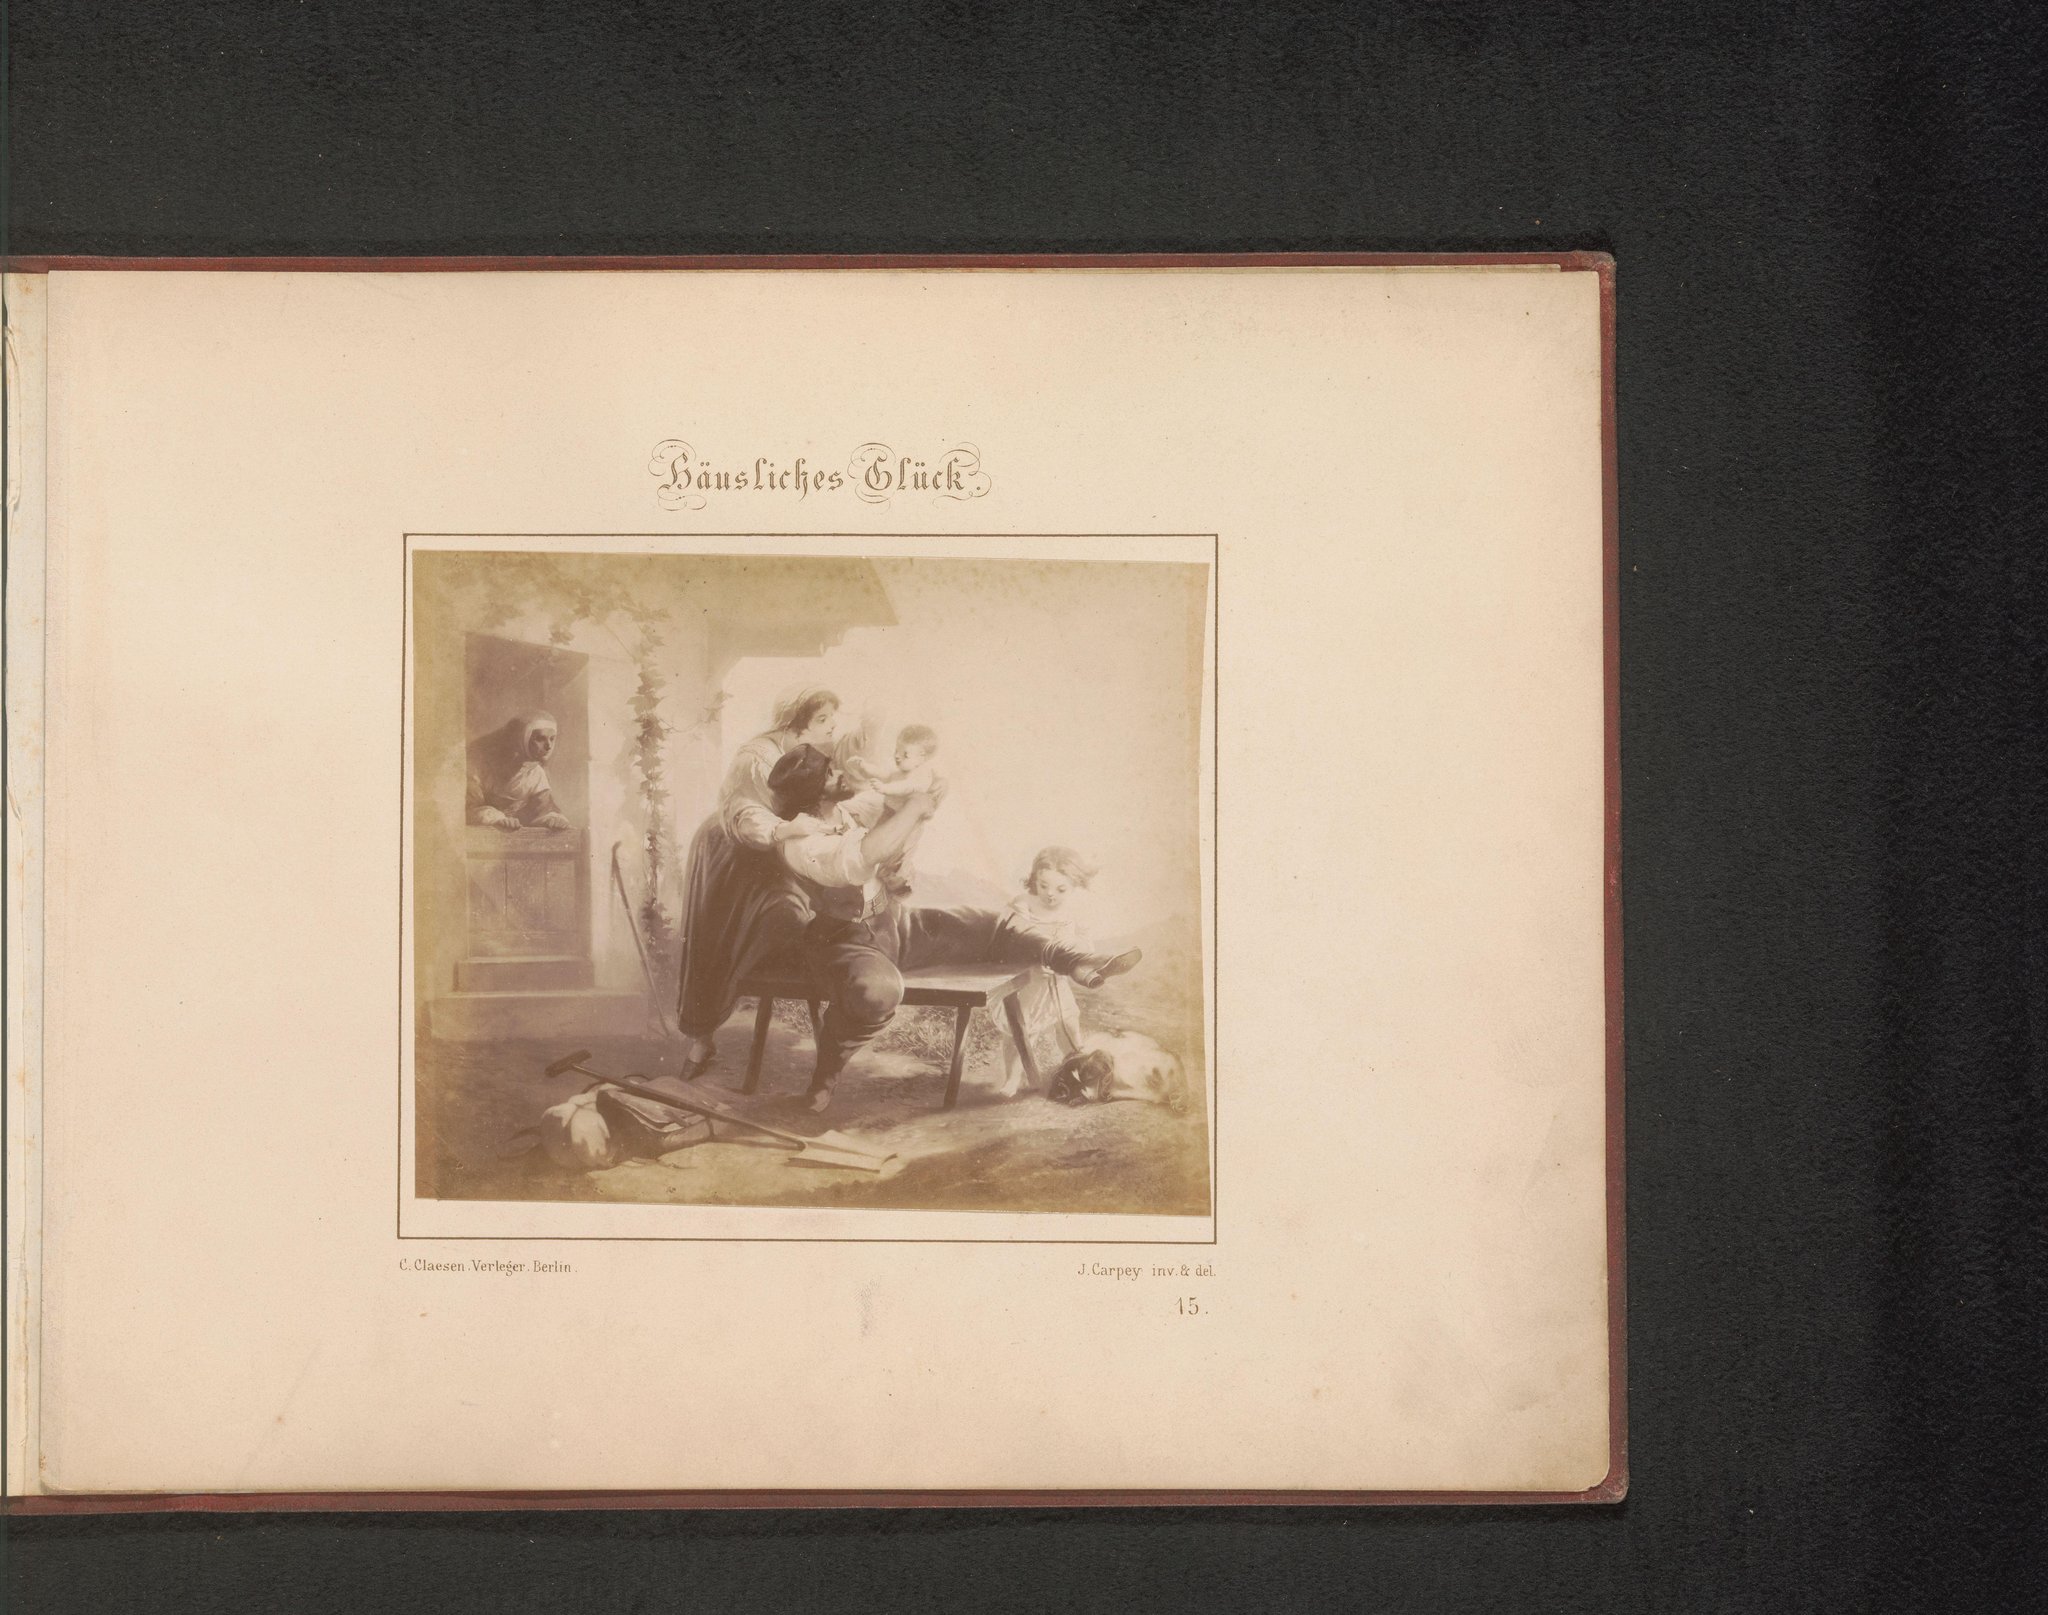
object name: page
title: Fotoreproductie van een ontwerp van een gelukkig gezin door J. Carpey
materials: photographic support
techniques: albumen print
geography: berlin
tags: family life at home, happy marriage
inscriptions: number: ‘15.’